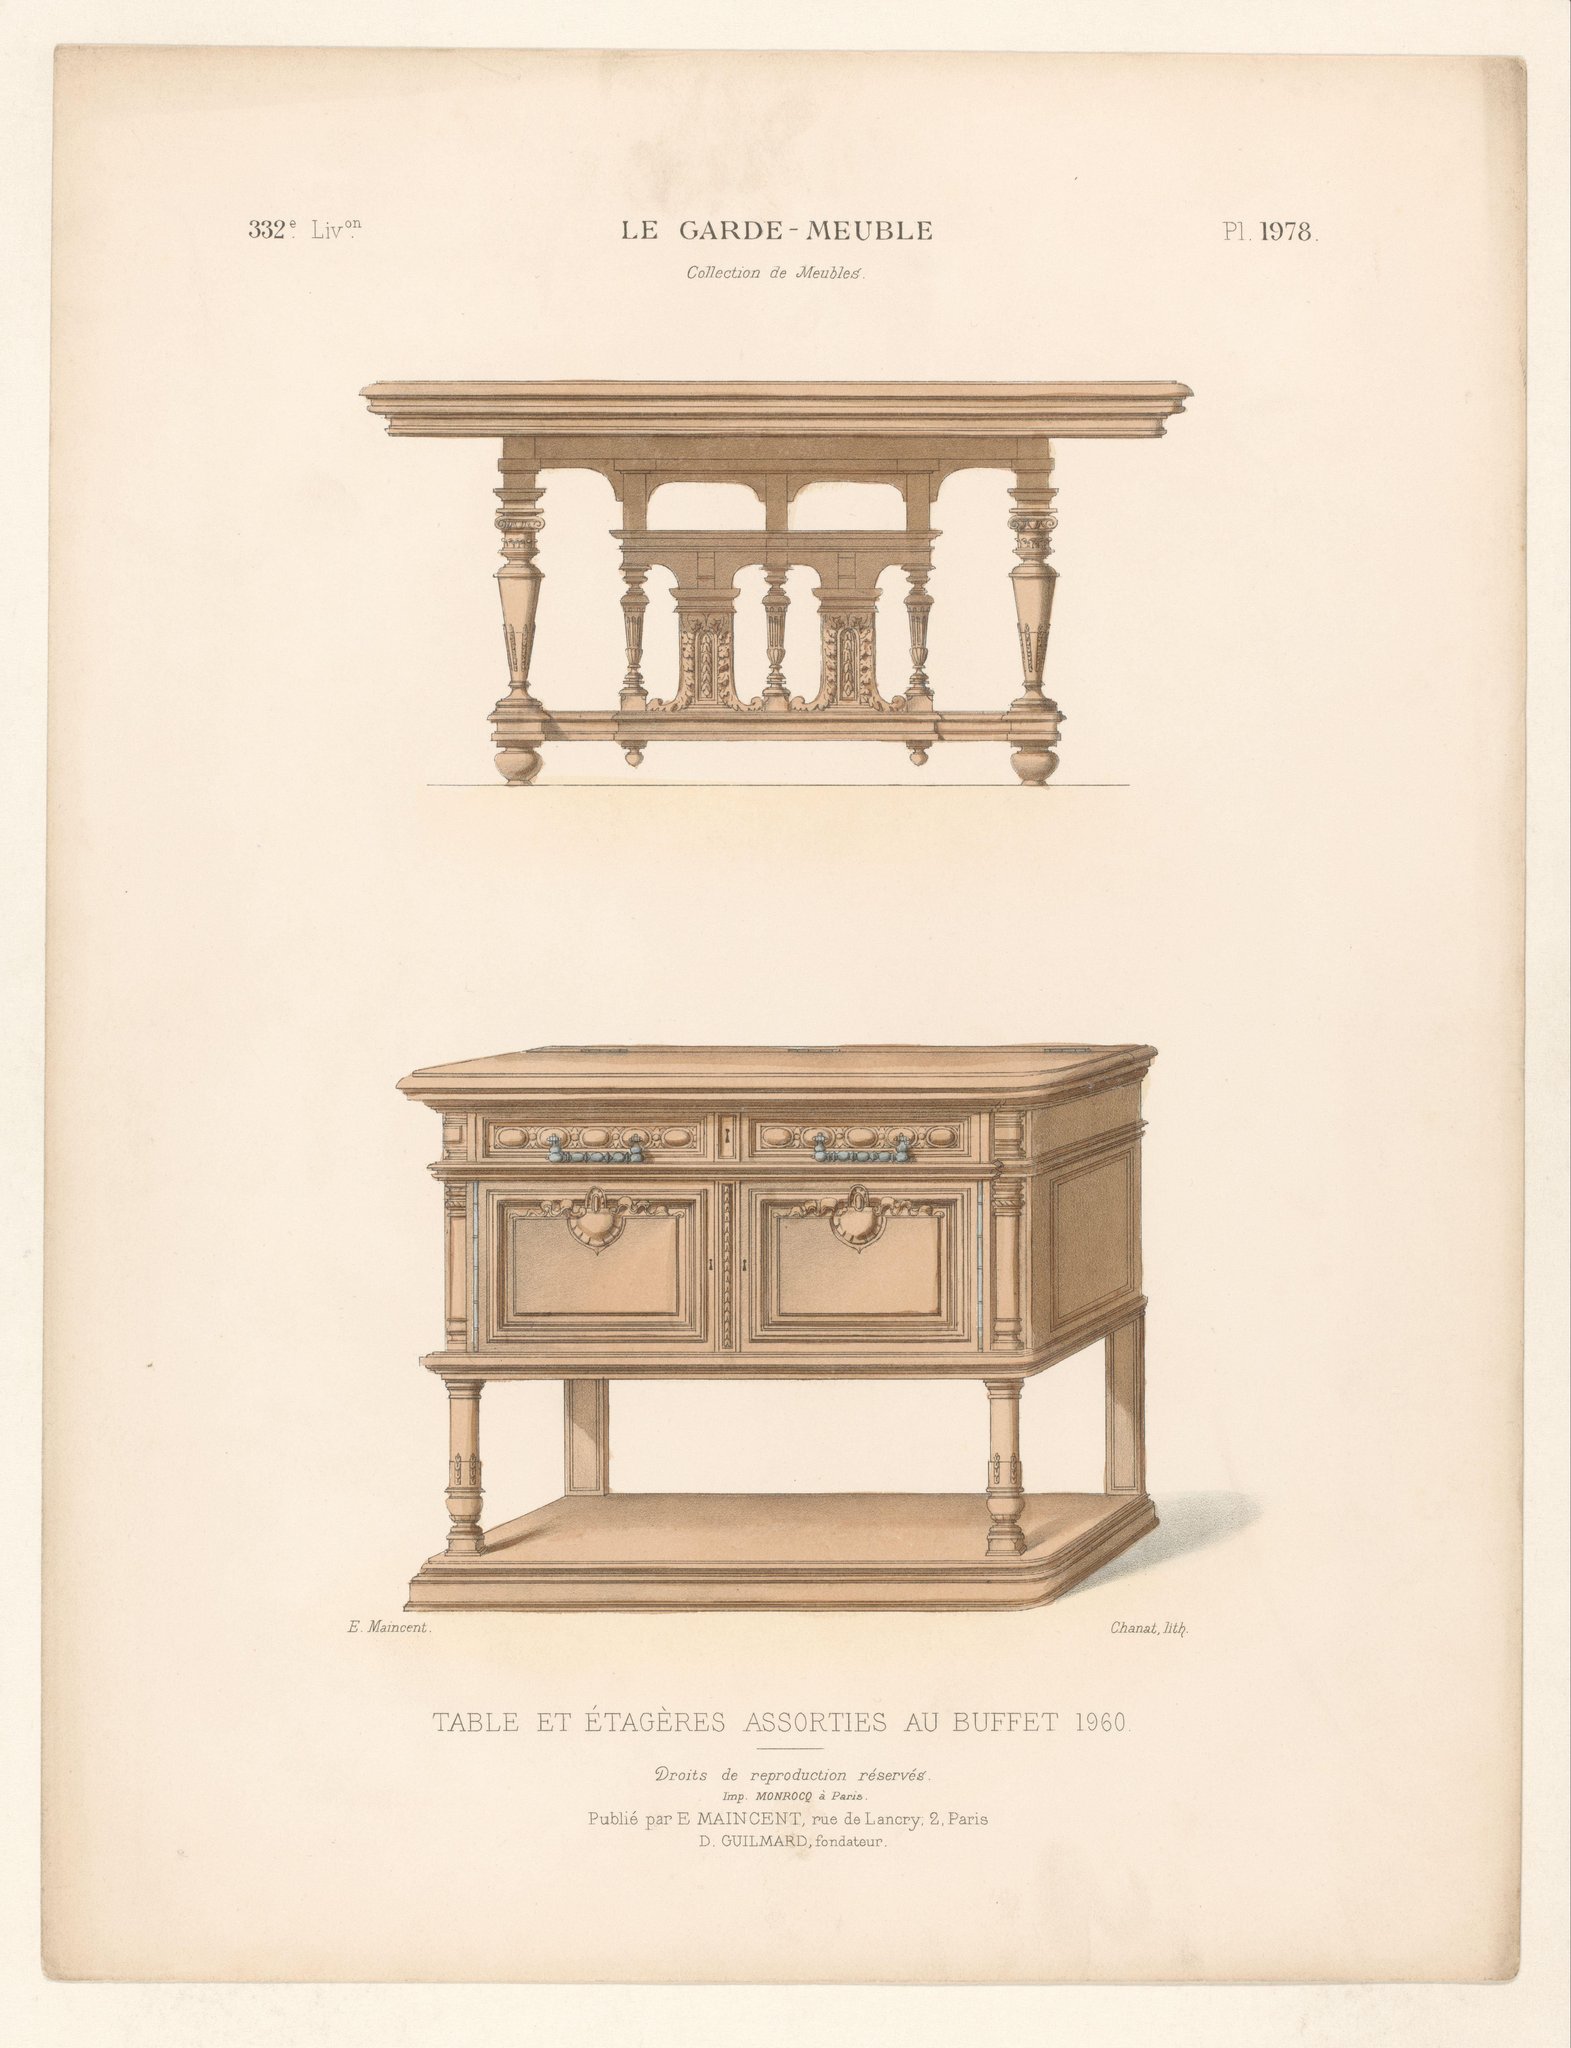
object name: print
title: Table et étagère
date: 1885-1895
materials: paper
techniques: hand coloring, lithograph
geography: paris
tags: furniture for storage, table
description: Ieder Livraison in de serie Le Garde-Meuble bevat negen platen: drie 'sièges' (zitmeubels), drie 'meubles' (diverse meubels zoals tafels en kasten) en drie 'tentures' (gordijnen en draperieën).